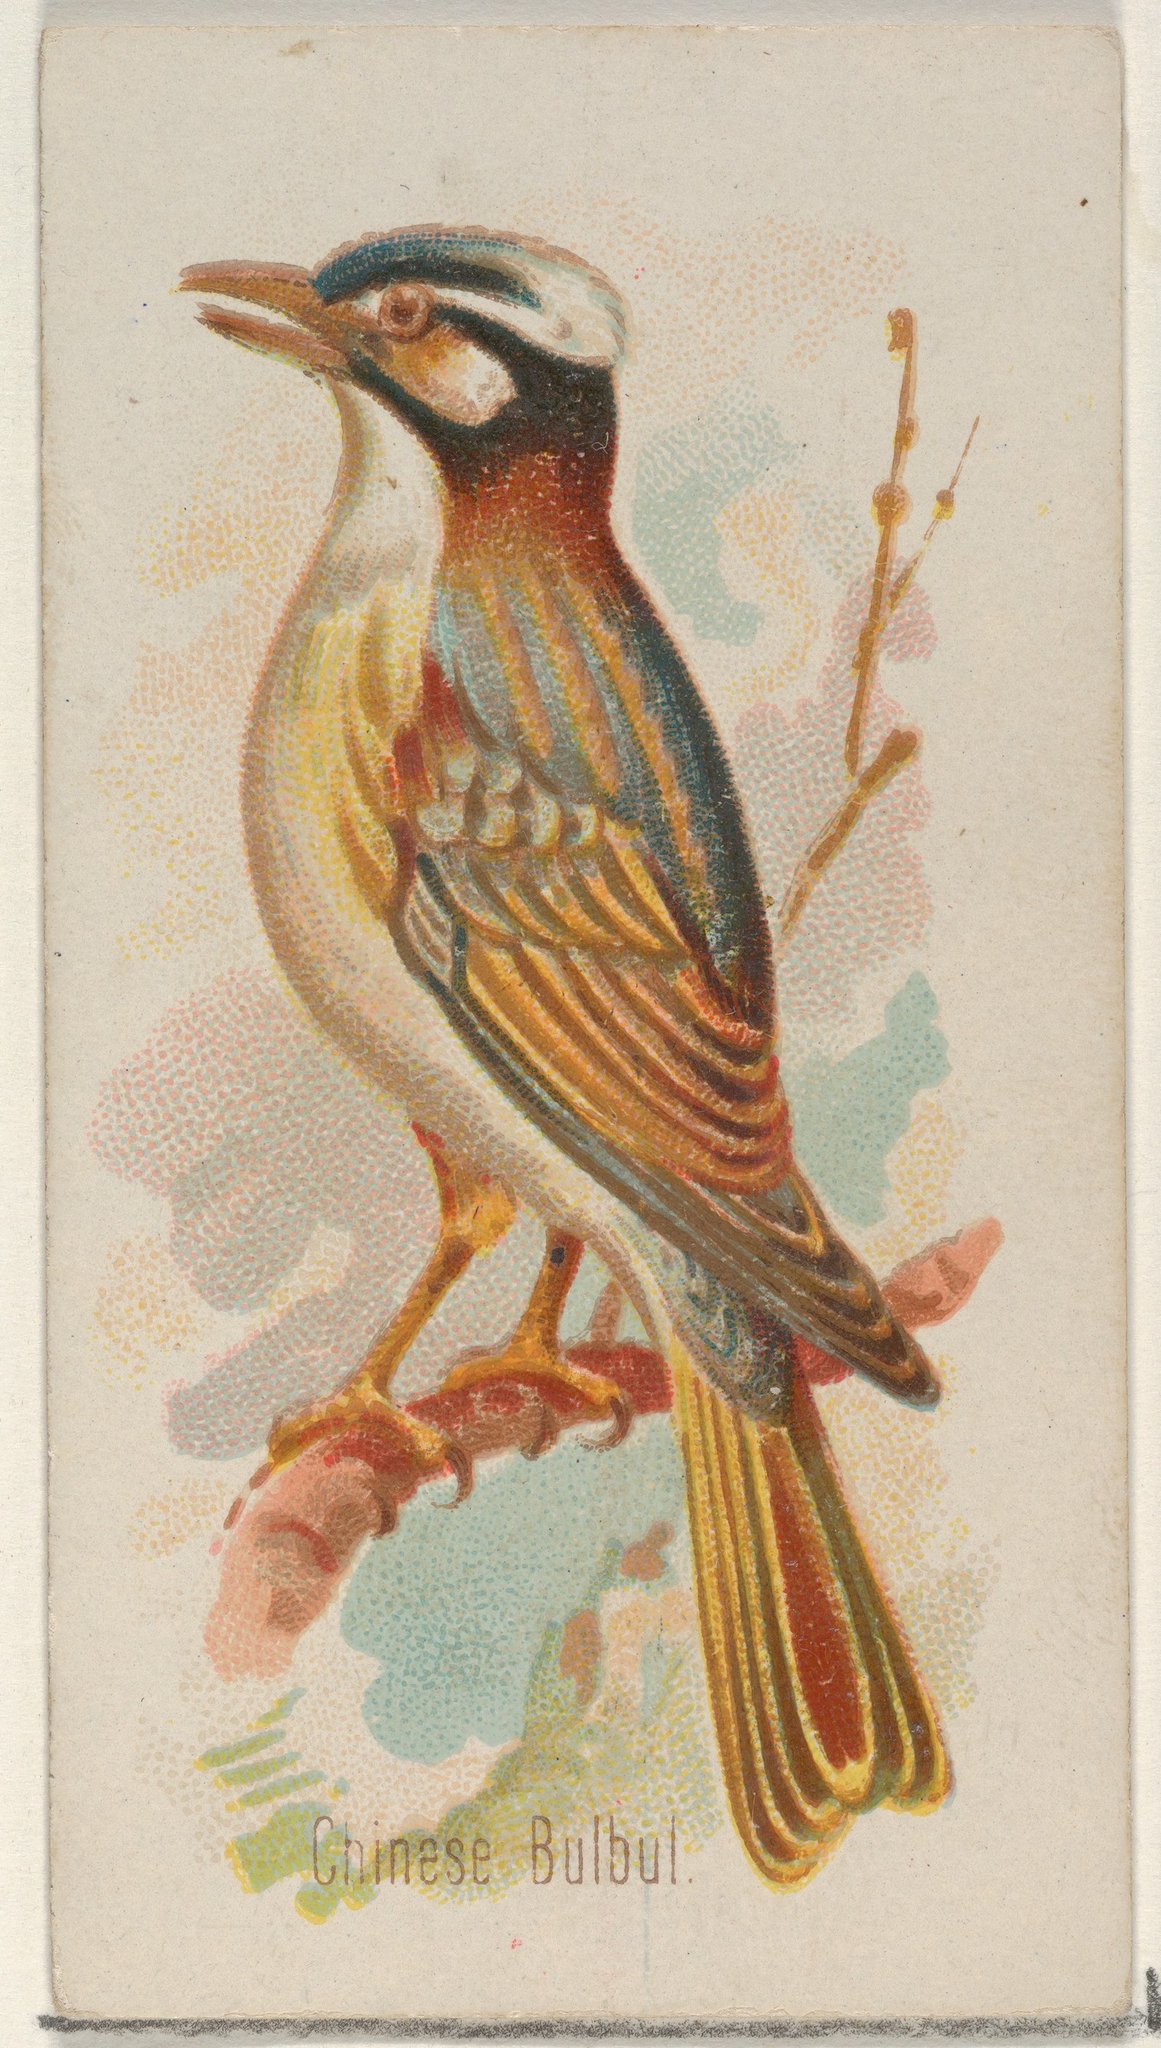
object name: print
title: Chinese Bulbul, from the Song Birds of the World series (N23) for Allen & Ginter Cigarettes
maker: allen & ginter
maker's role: publisher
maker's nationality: american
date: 1890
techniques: color lithograph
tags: birds